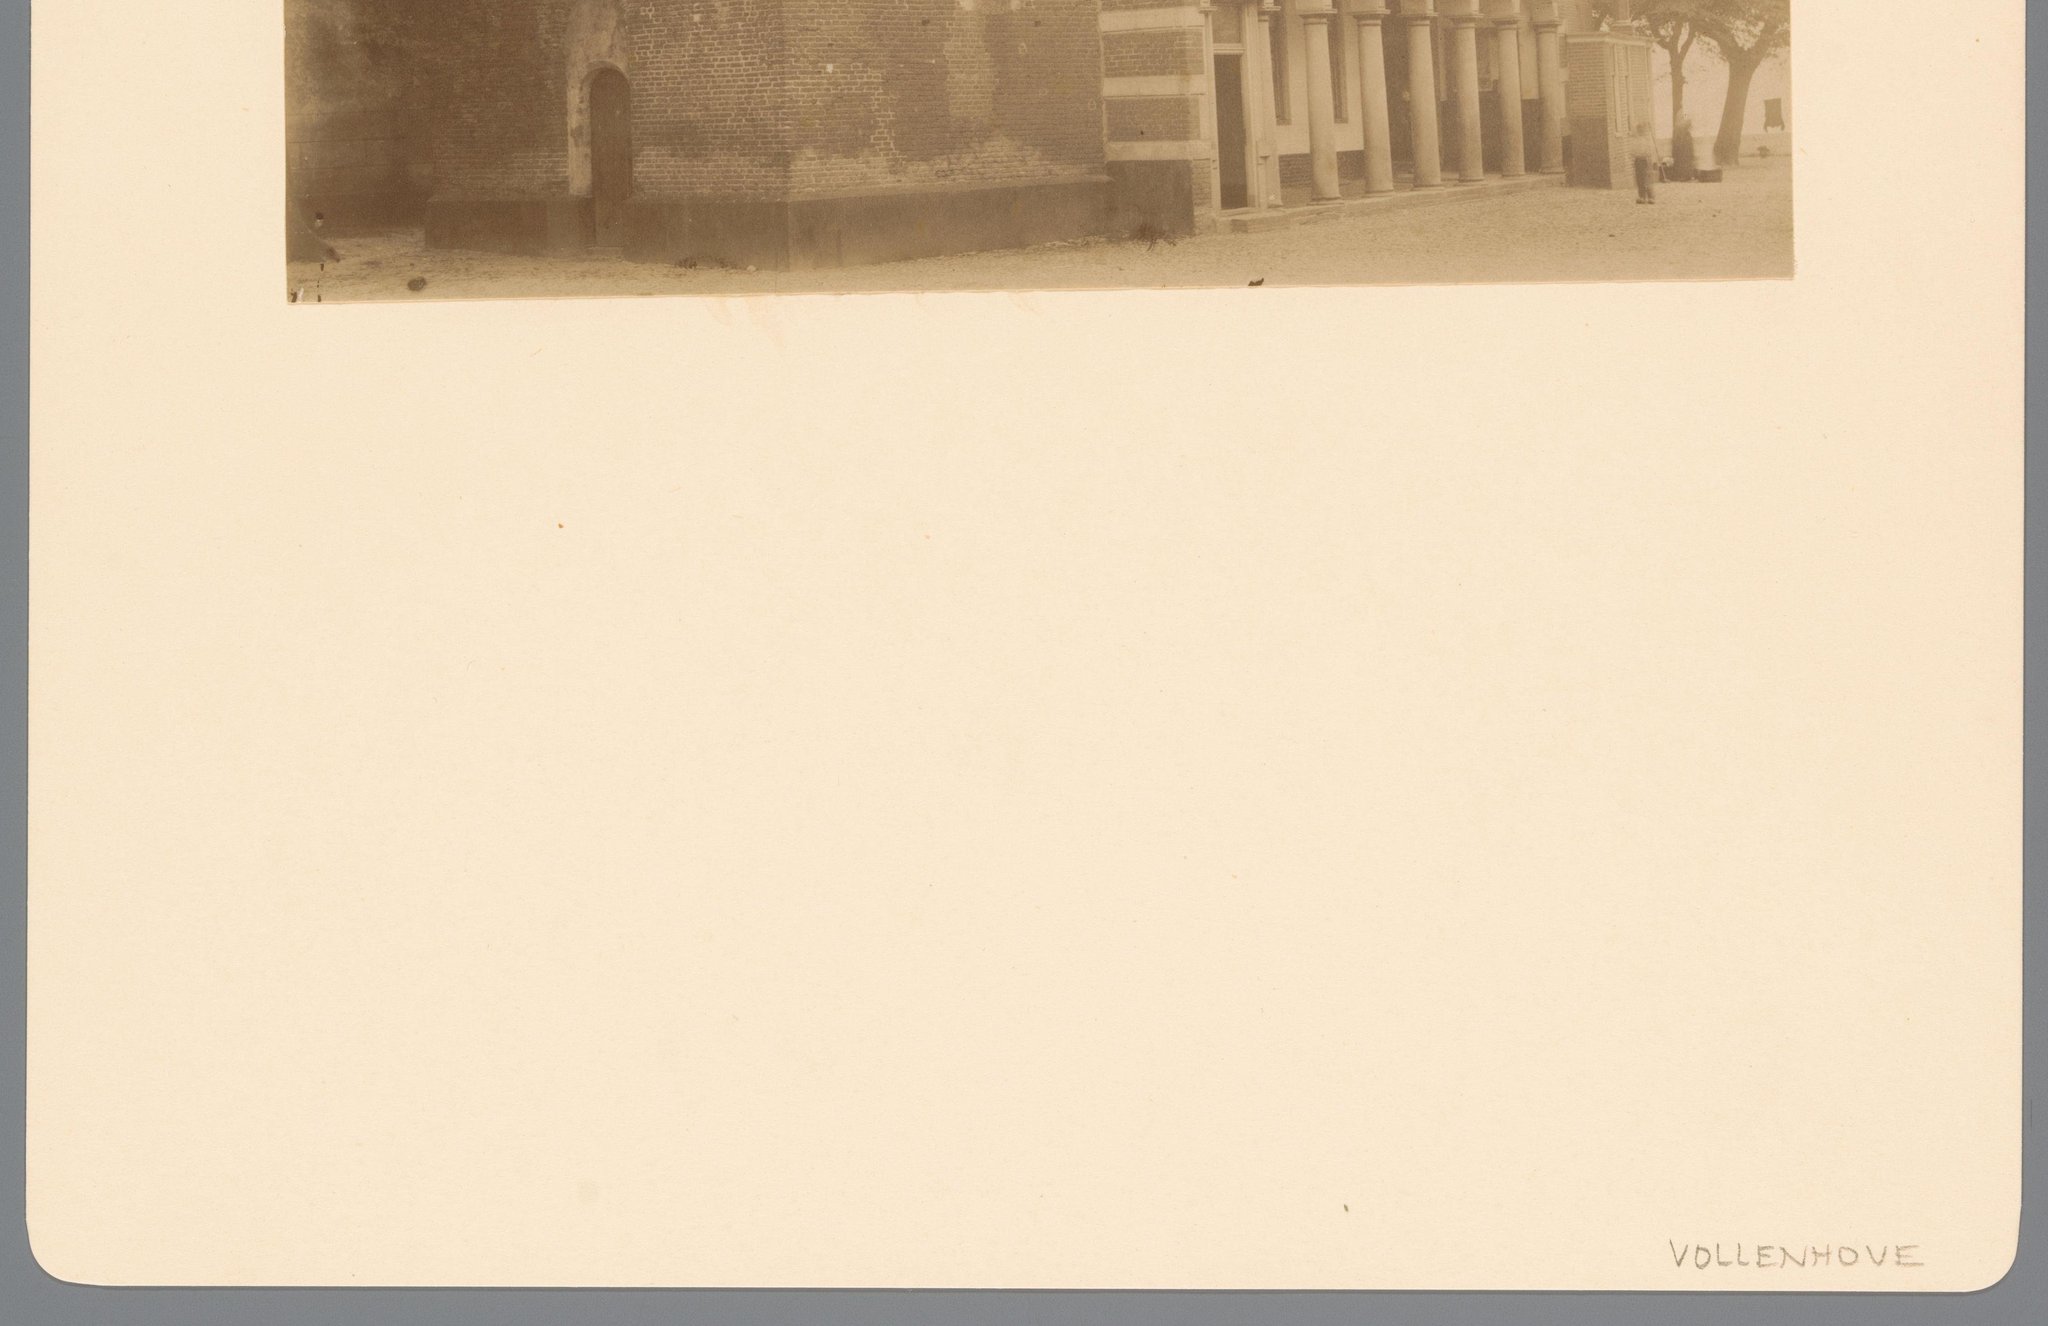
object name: photograph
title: Gezicht op het stadhuis van Vollenhove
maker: anoniem (monumentenzorg)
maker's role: fotograaf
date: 1898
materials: cardboard, photographic support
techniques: albumen print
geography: vollenhove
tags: townhall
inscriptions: annotation: ‘Vollenhove’, annotation: ‘Raadhuis te Vollenhove (O.IJ.) aug 1898’